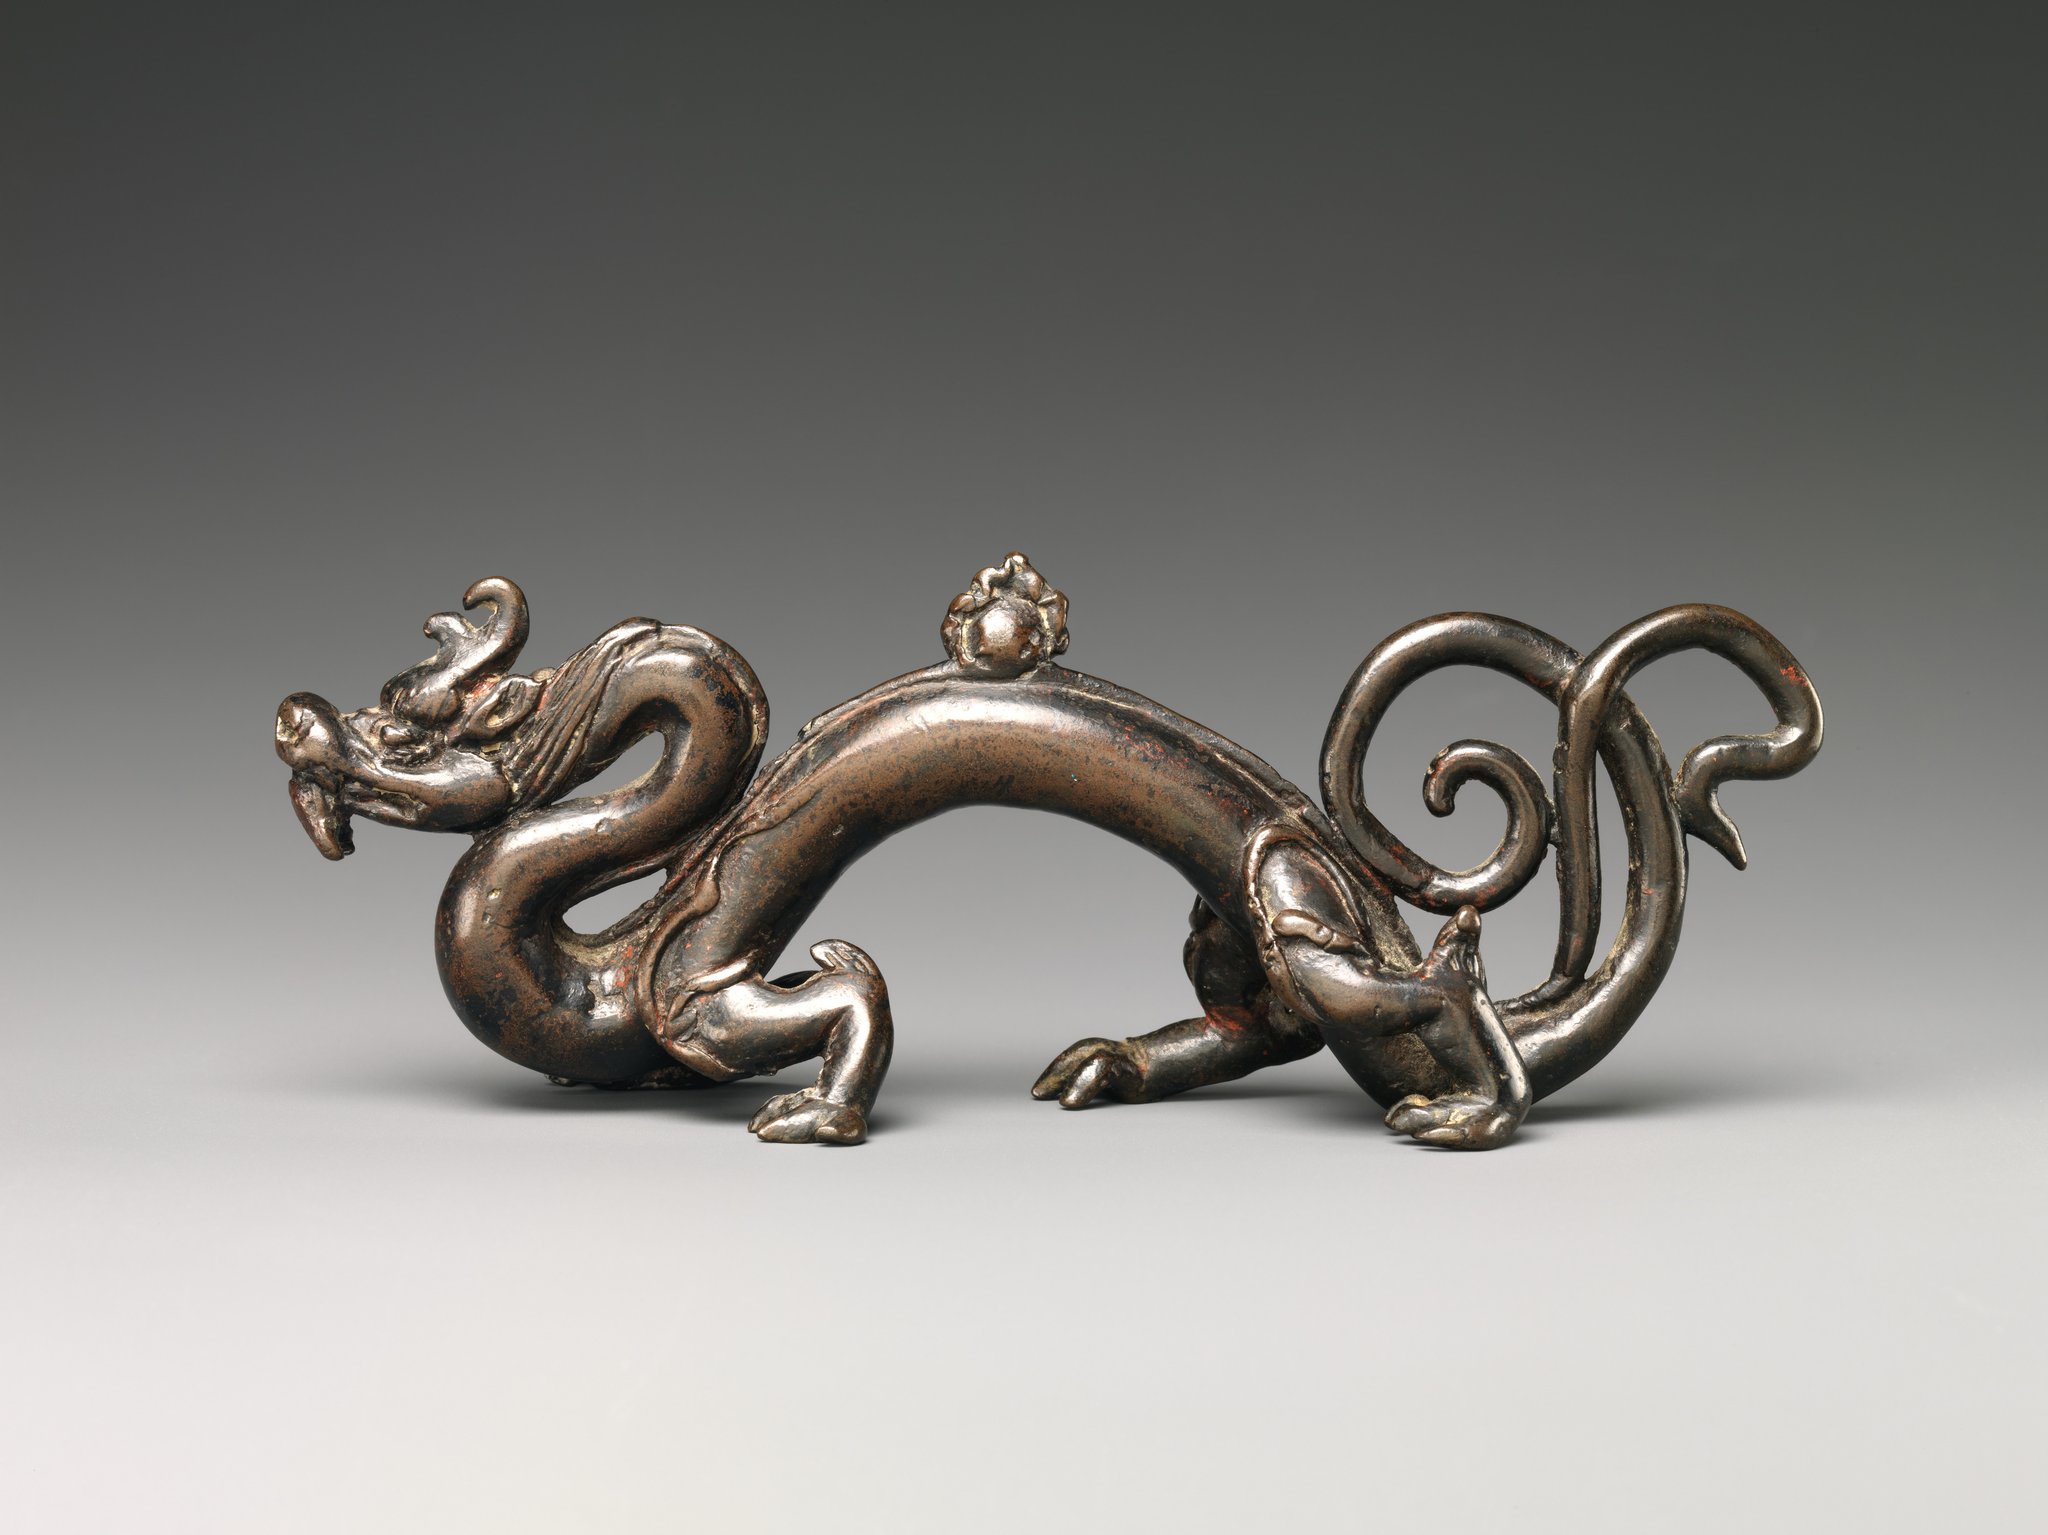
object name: brush rest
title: Brush rest in the shape of a dragon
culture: chinese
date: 1301-1400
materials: copper alloy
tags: dragons